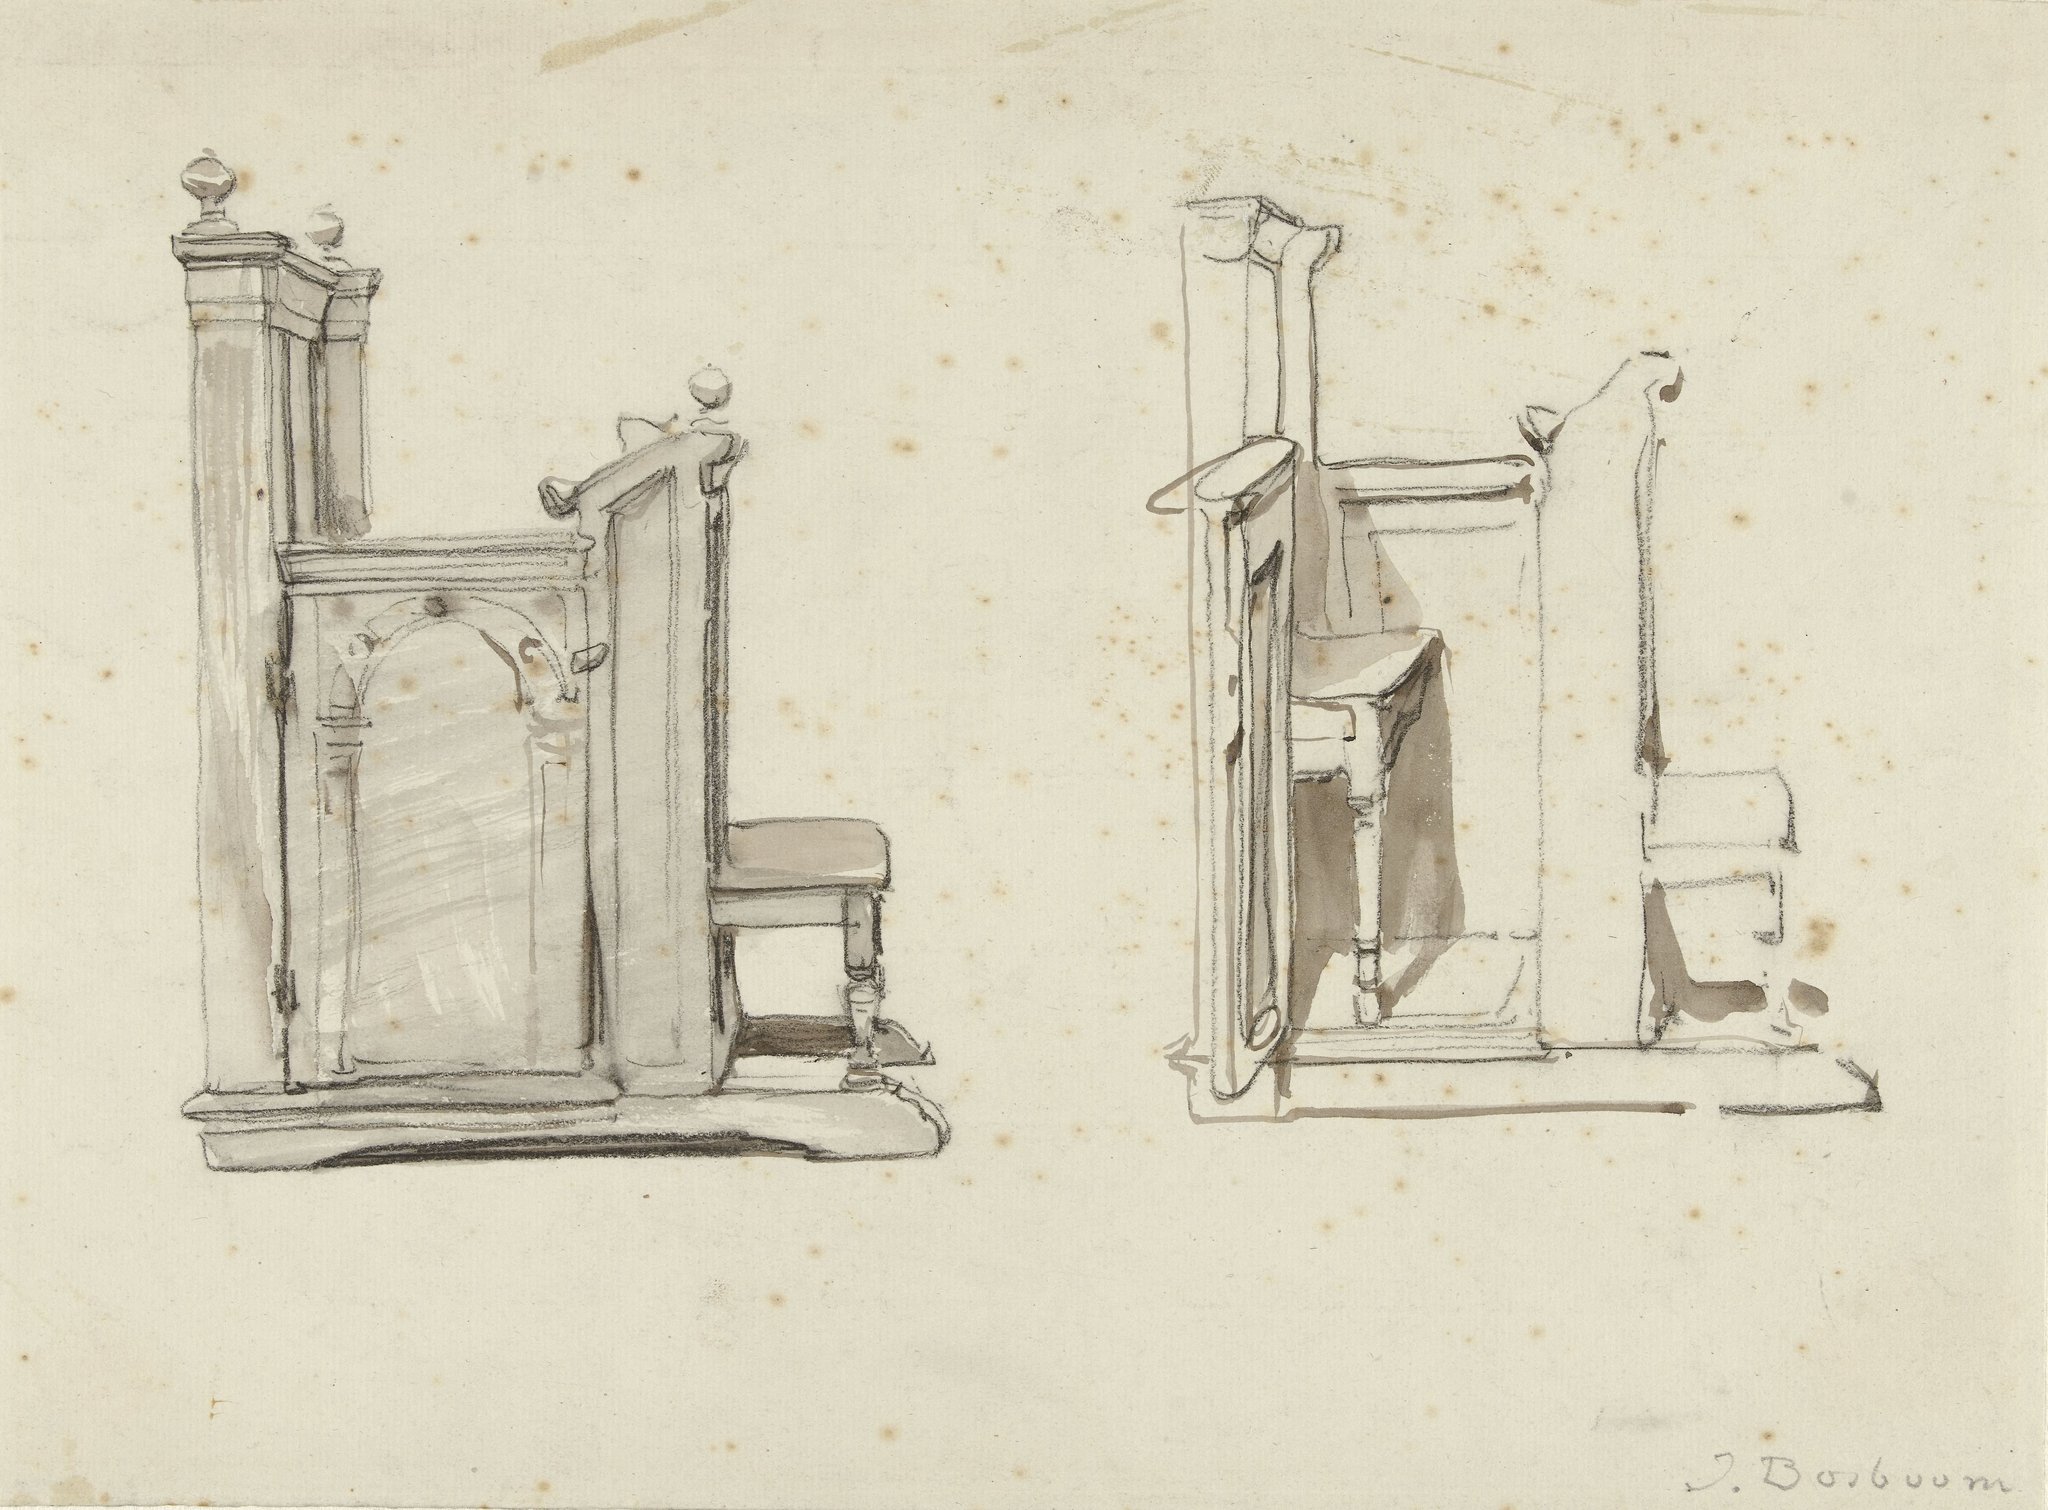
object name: drawing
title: Kerkbanken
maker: johannes bosboom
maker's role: draughtsman, painter, print maker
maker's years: 1817-1891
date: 1827-1891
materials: chalk, paper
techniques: brush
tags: liturgical furniture, etc.